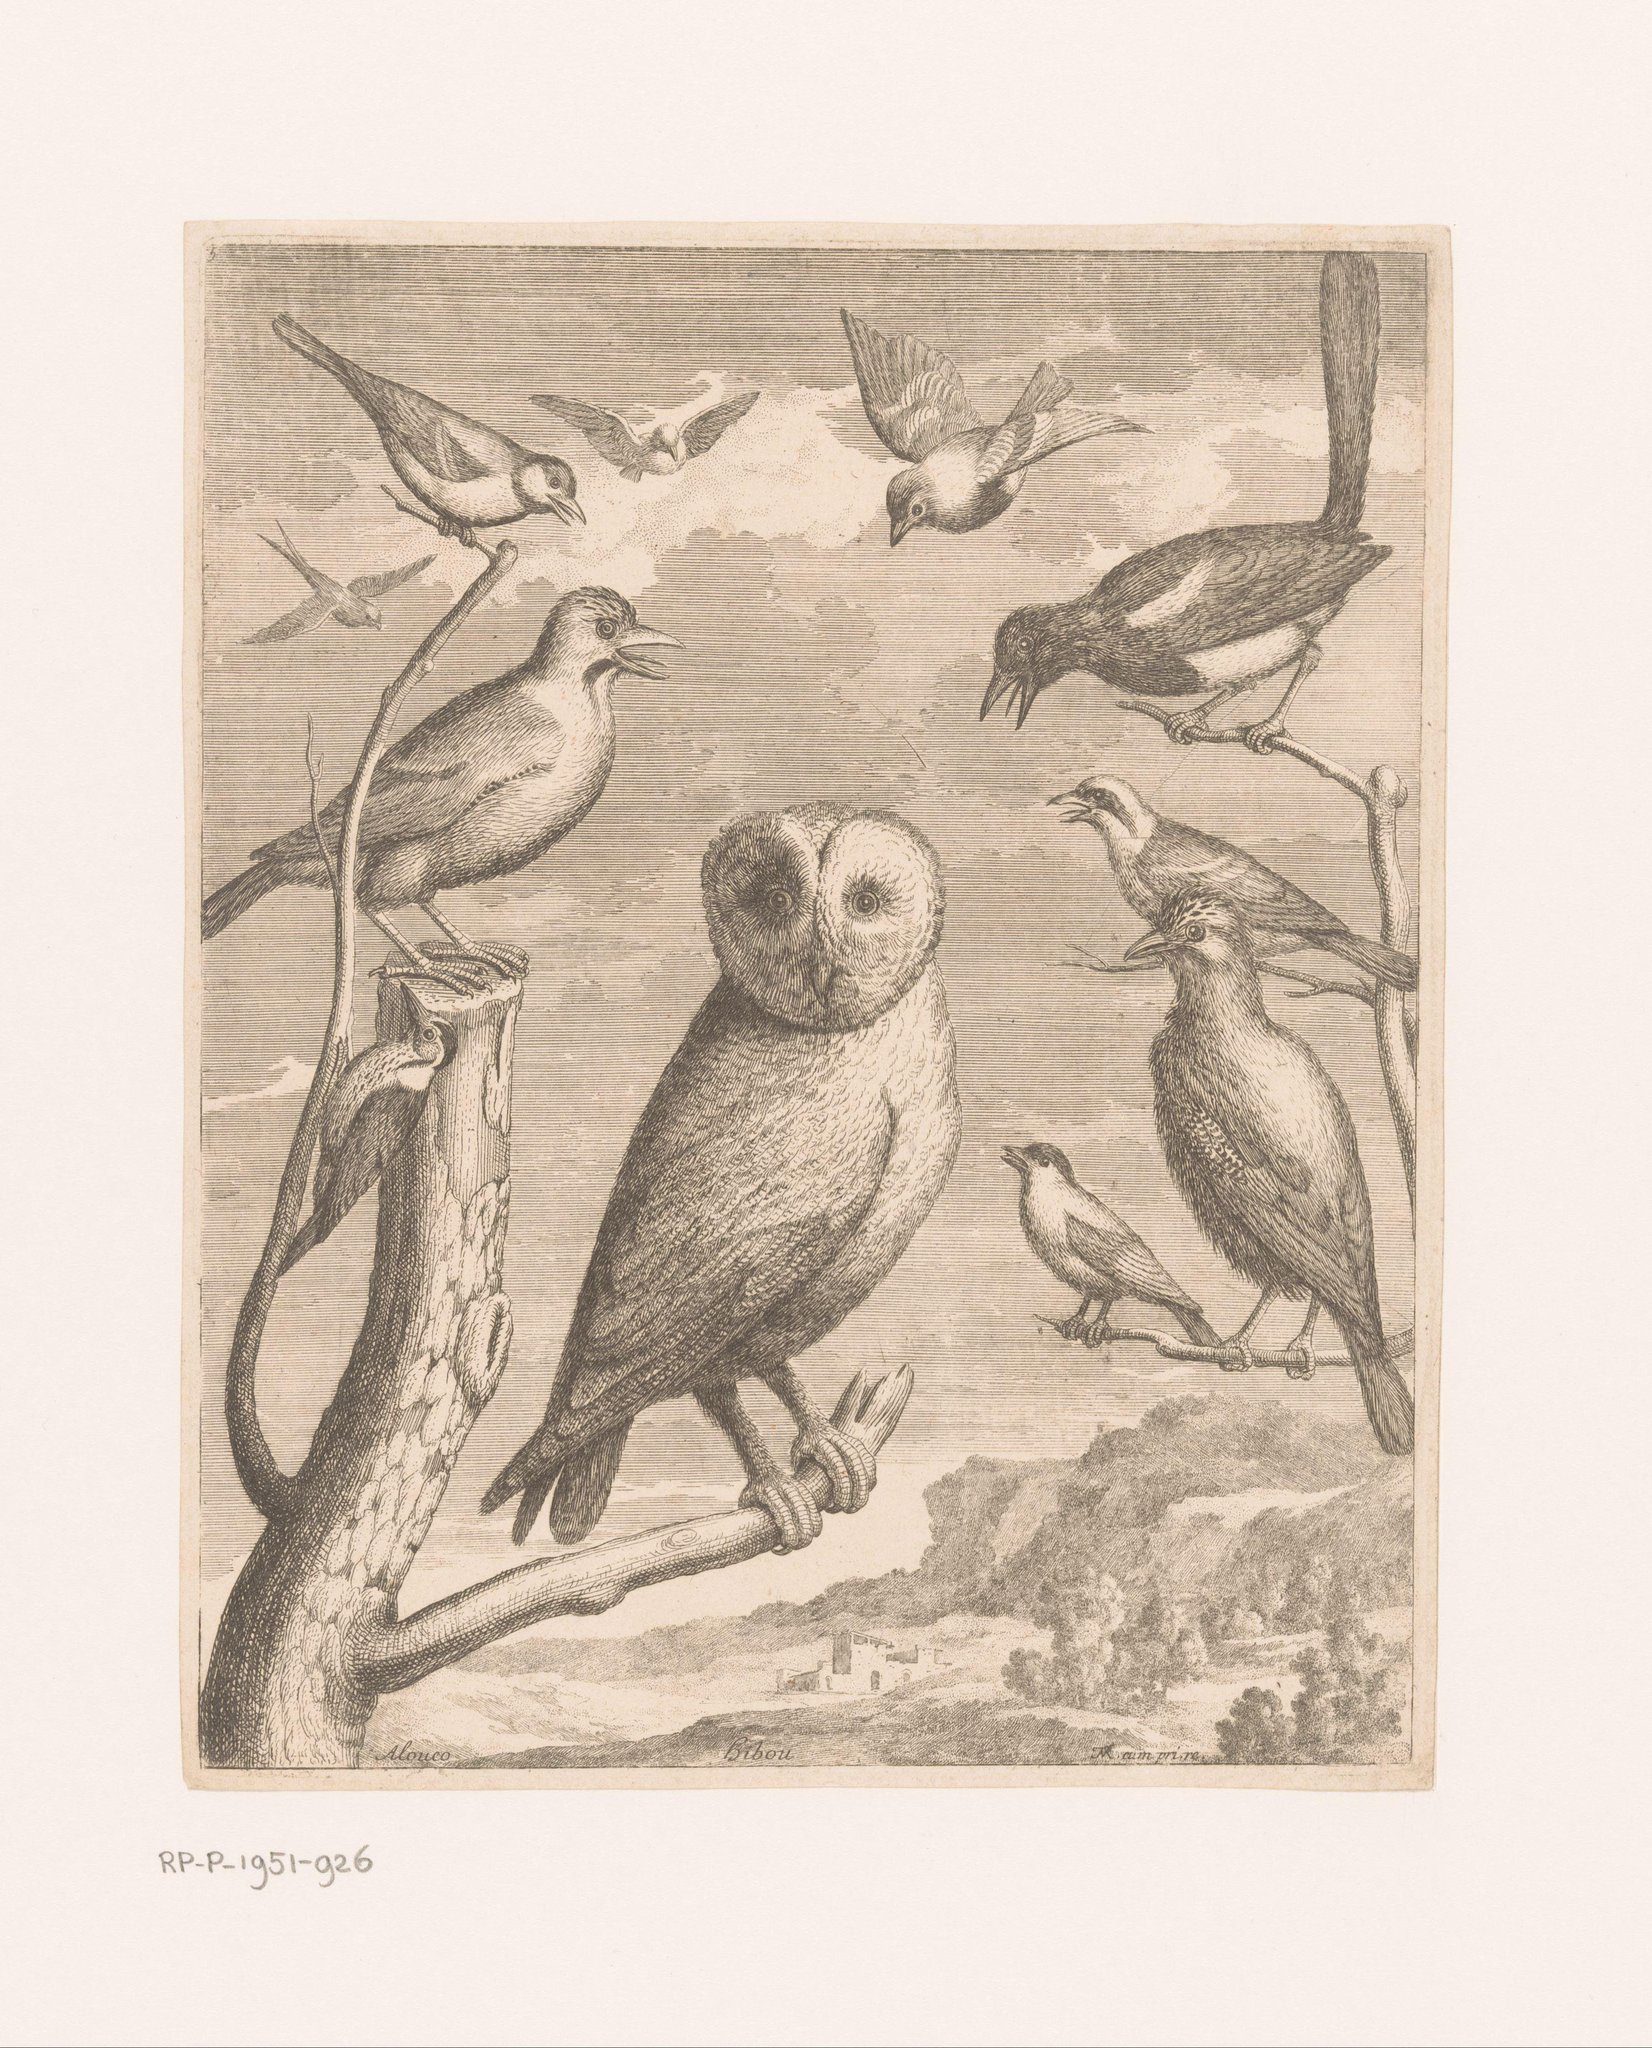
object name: print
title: Vogels uit de dierentuin van Versailles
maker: lodewijk xiv (koning van frankrijk)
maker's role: koning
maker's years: 1638-1715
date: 1655-1682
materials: paper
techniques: etching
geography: france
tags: birds, owls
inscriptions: collector's mark: Lugt 2228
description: Er zijn twee series over vogels, namelijk "Suite des Oyseaux les plus rares qui se voyent à la Menagerie" en "Receüil d'oyseaux les plus rares tirez de la ménagerie royalle du parc de Versailles". In de literatuur worden ze samen onder één nummer genoemd. Volgens het British Museum maakt deze prent mogelijk deel uit van zes extra prenten bij deze series, door anoniem naar Robert, zie museum number 1919,1216.77.